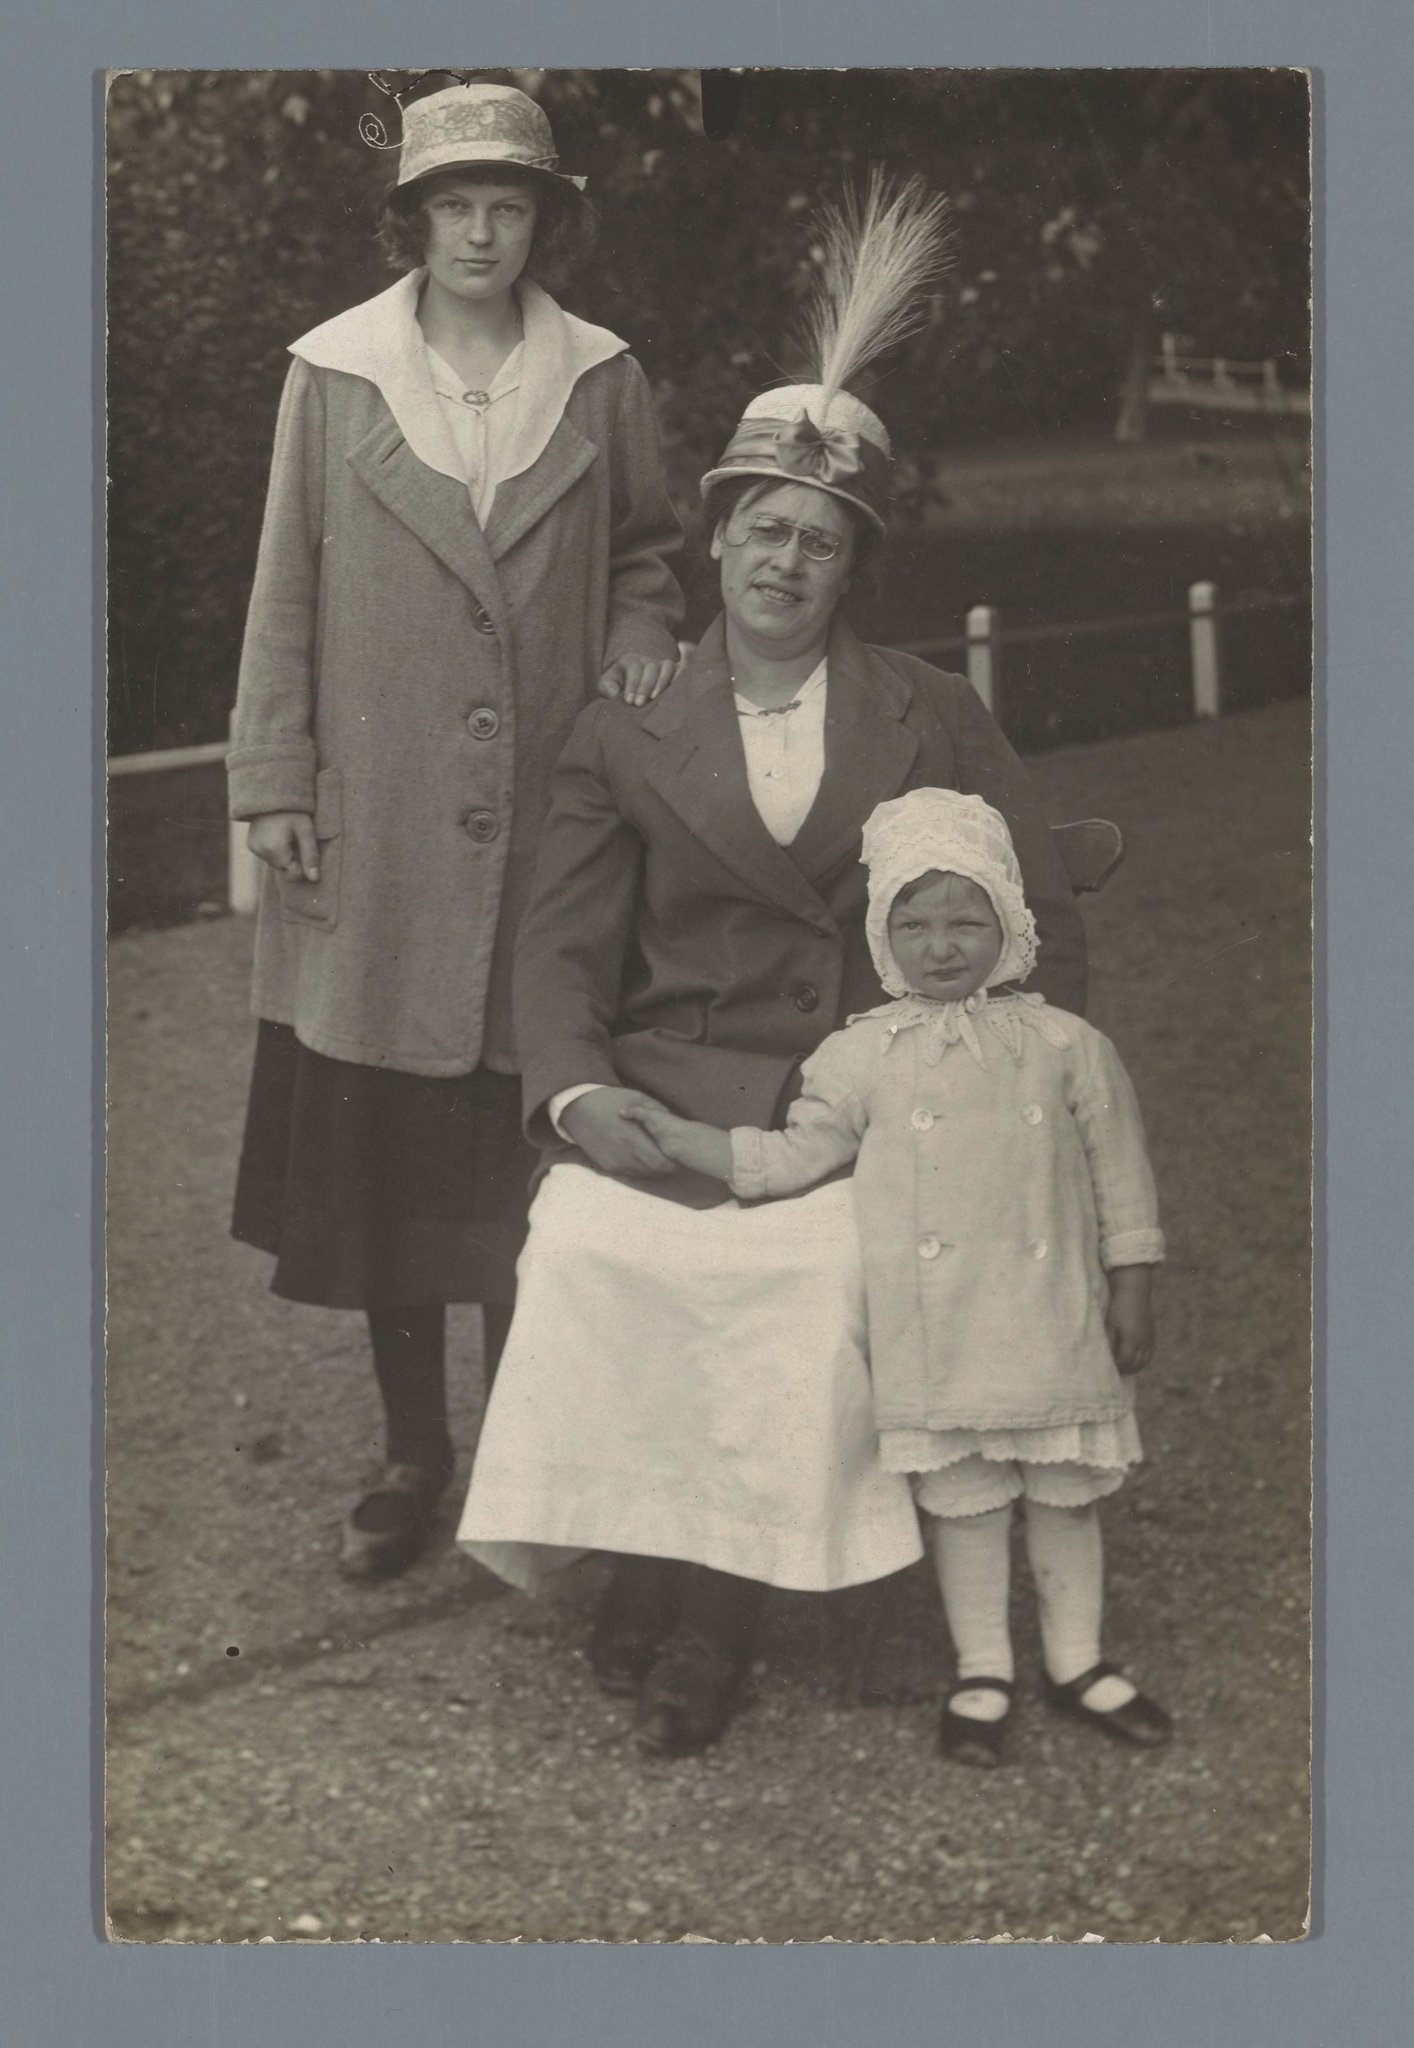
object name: ansichtkaart, prentbriefkaart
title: Portret van twee onbekende vrouwen en een kind in een park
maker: Anonymous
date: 1907-1920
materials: photographic support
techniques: gelatin silver print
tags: park, mother and child(ren), woman and child(ren) (family group)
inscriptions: inscription: ‘Tonia mevr. v Dam & dochter’